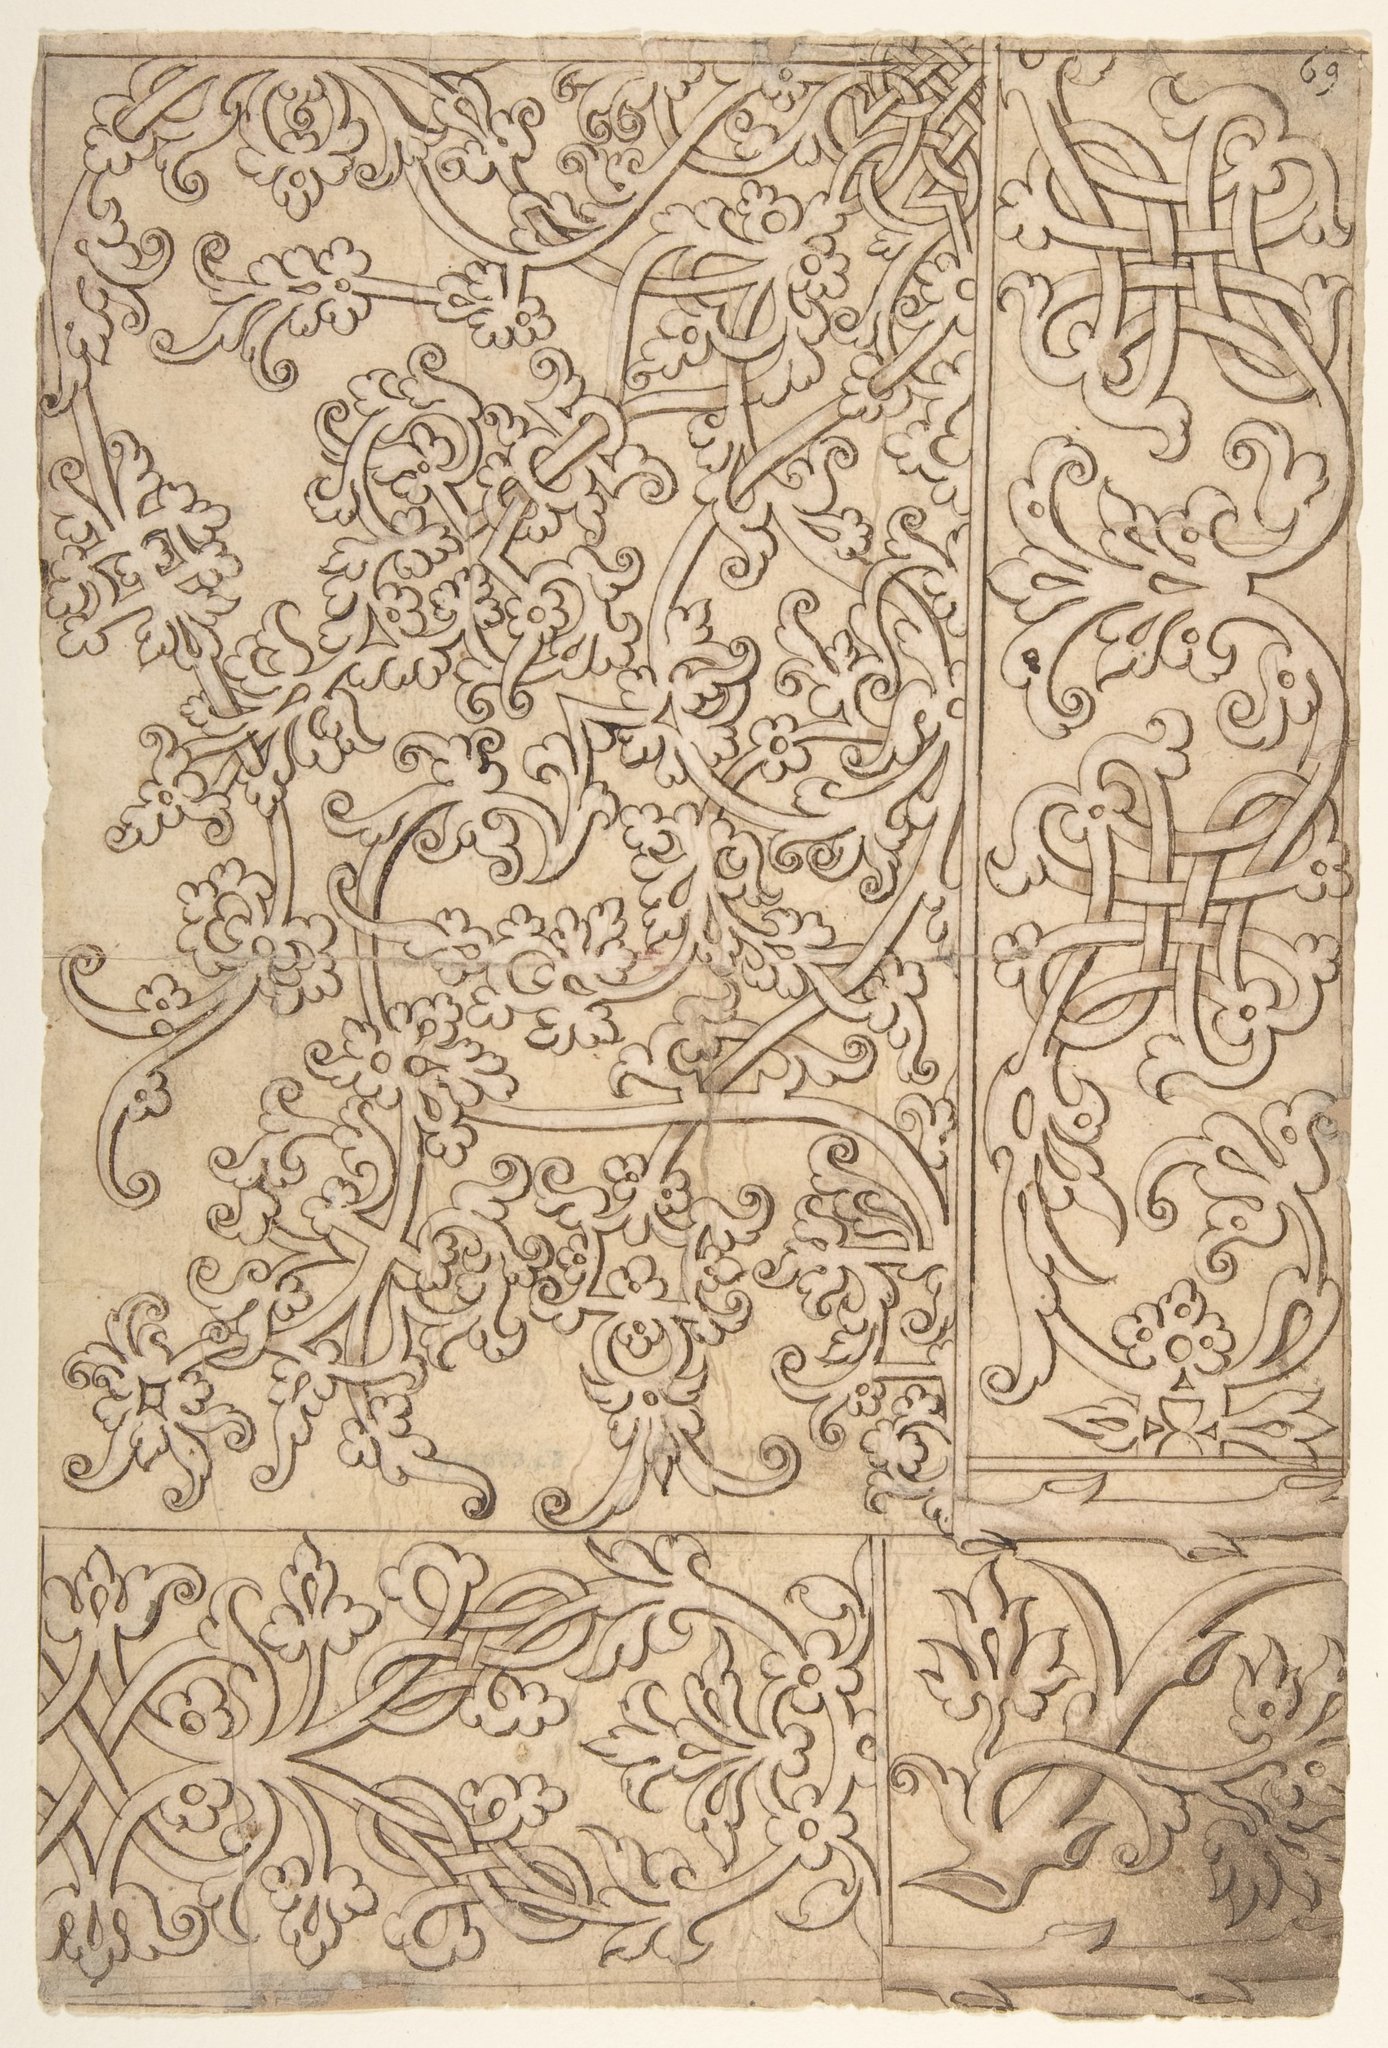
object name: drawing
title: Design for Panels (Textile?) Decorated with Moresque and Knotwork Ornament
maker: master f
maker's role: artist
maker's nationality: italian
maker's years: 1525-1540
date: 1525-1540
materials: ink, drawing material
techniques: pen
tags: ornament,leaves